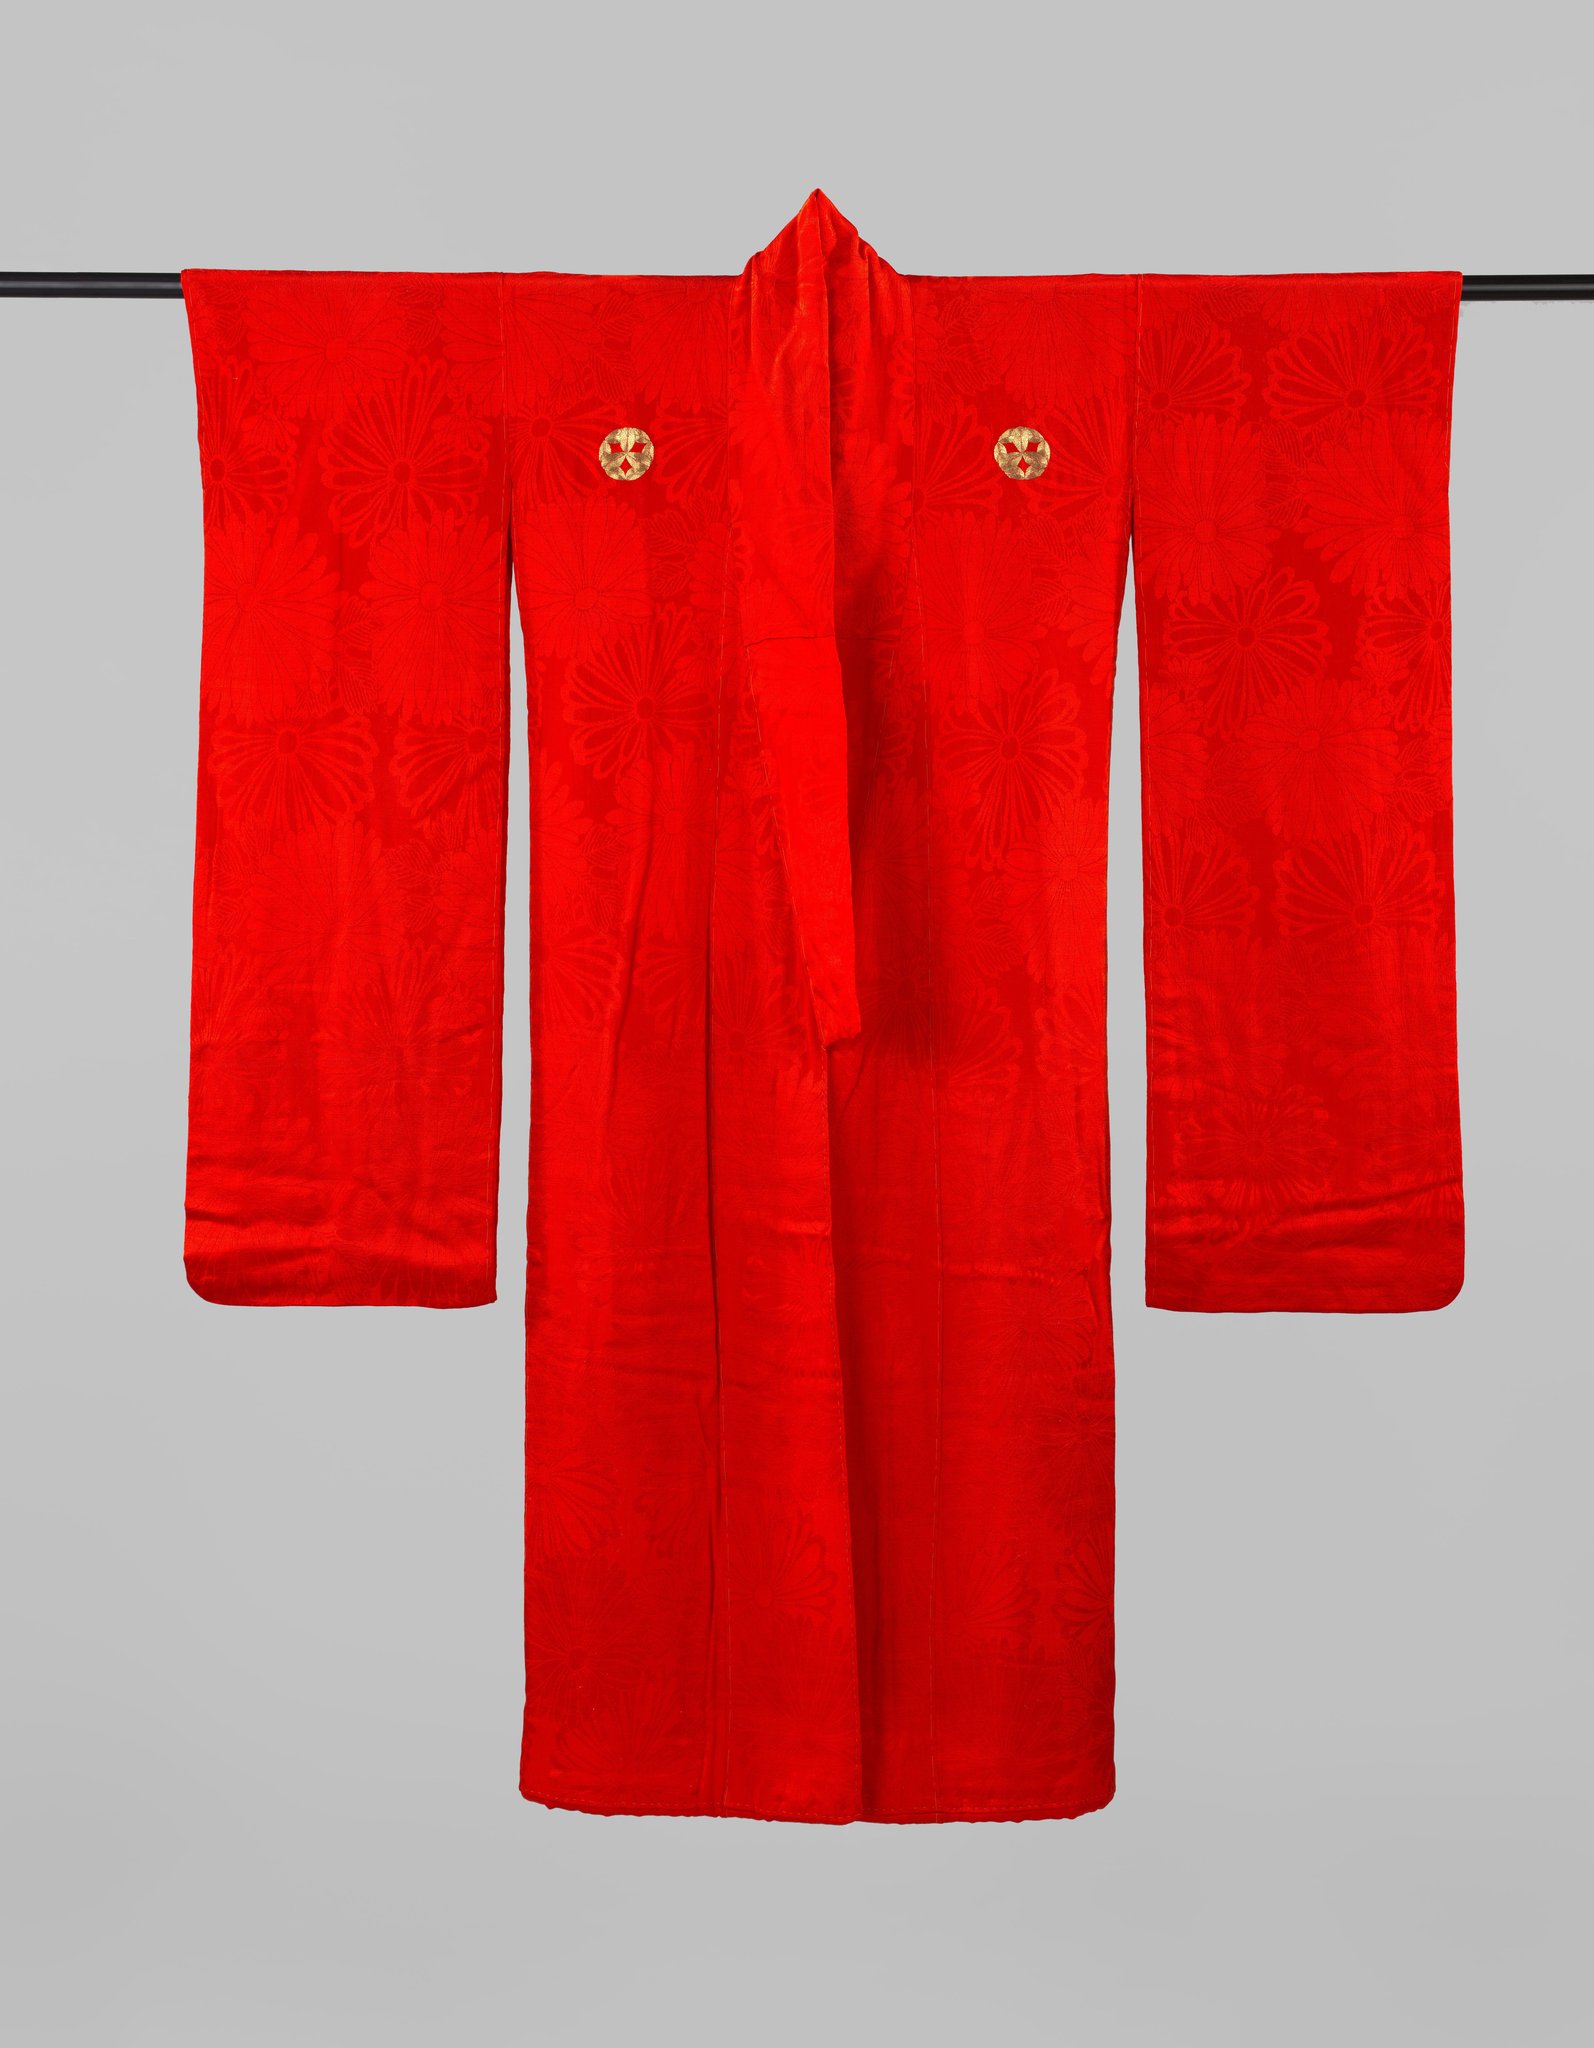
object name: kimono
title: Bruids-nagajuban met chrysanten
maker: Anonymous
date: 1920-1940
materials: silk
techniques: painting, weave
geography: japan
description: Onderkimono (nagajuban) voor een bruidskimono met een versiering van grote chrysant-motieven. Rode crepe zijde (chirimen) met damast geweven decoratie en detaillering in gouddraad. Voering van rode zijde. Vijf familiewapens (mon) van bamboeblad.